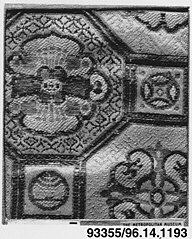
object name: piece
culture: japanese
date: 1701-1900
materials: silk